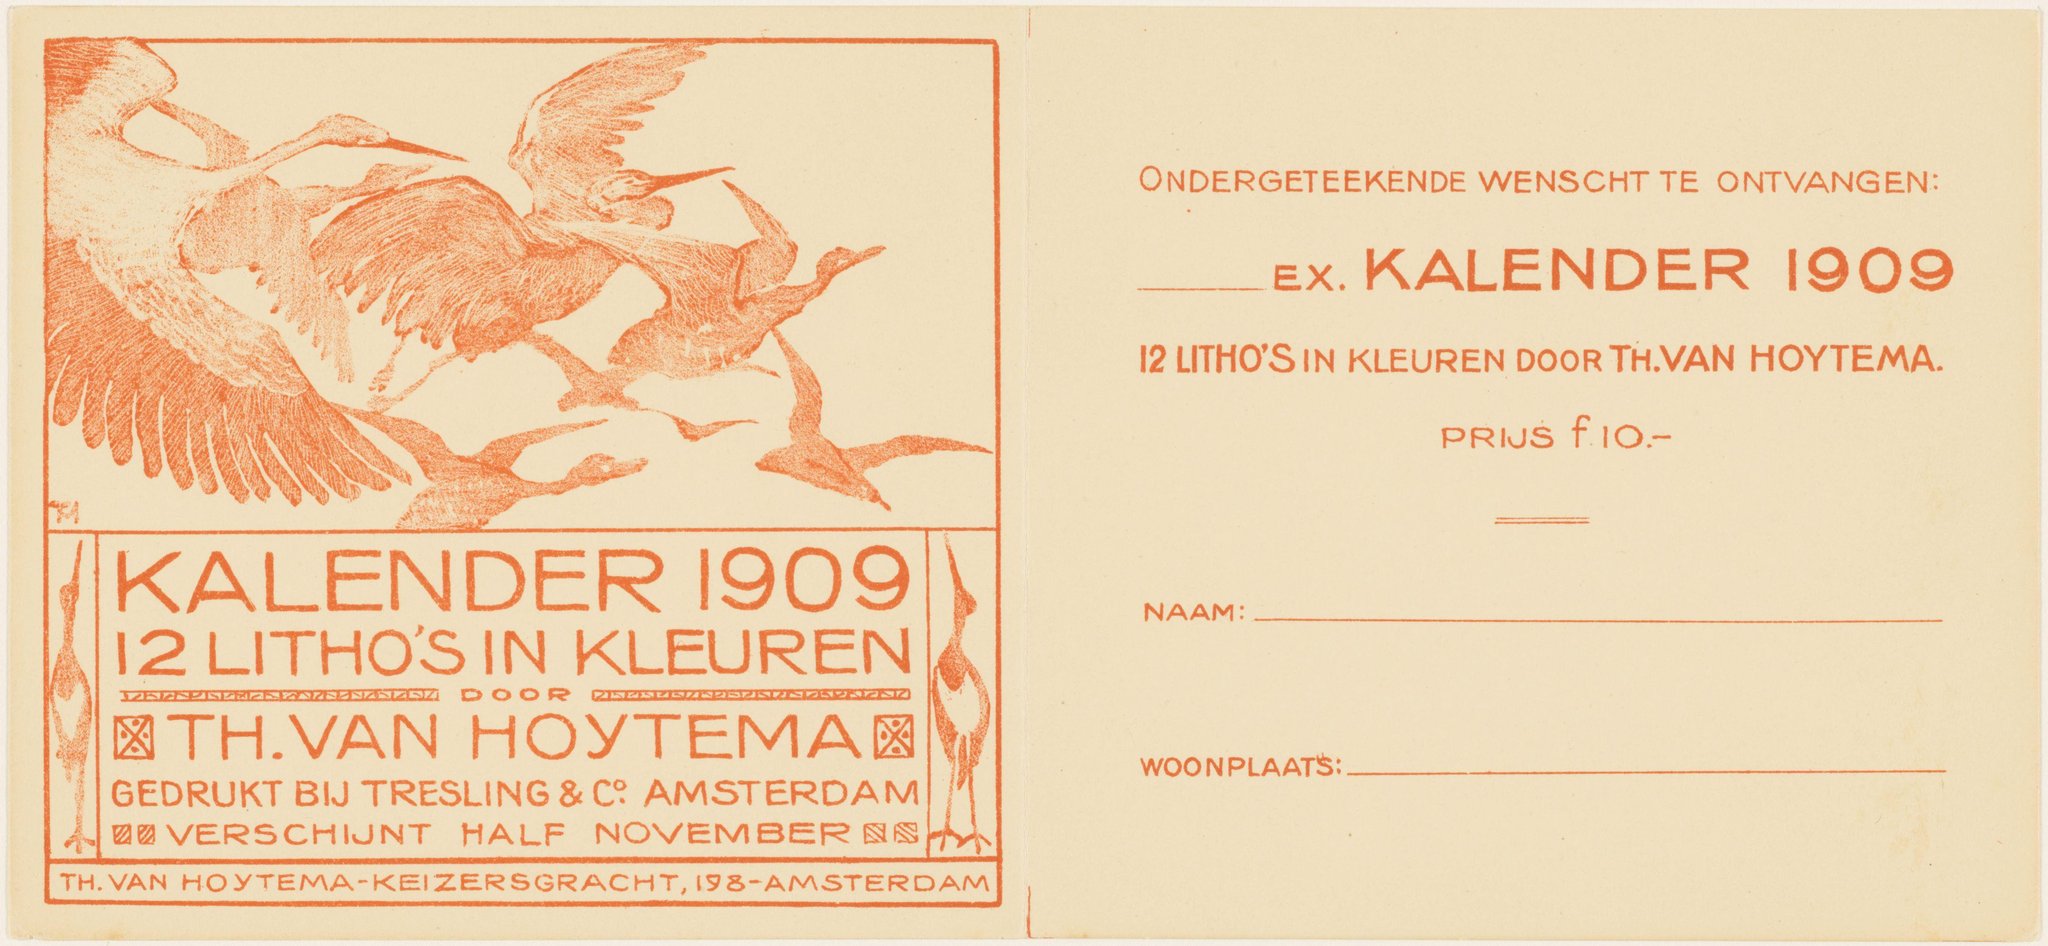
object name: print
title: Aankondiging voor kalender 1909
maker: theo van hoytema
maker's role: draughtsman, painter, print maker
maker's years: 1863-1917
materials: paper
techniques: lithograph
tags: shore-birds and wading-birds: crane, birds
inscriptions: collector's mark: Lugt 2228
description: Links vliegende vogels en tekst met aan weerszijden een kraanvogel. Rechts een bestelformulier.